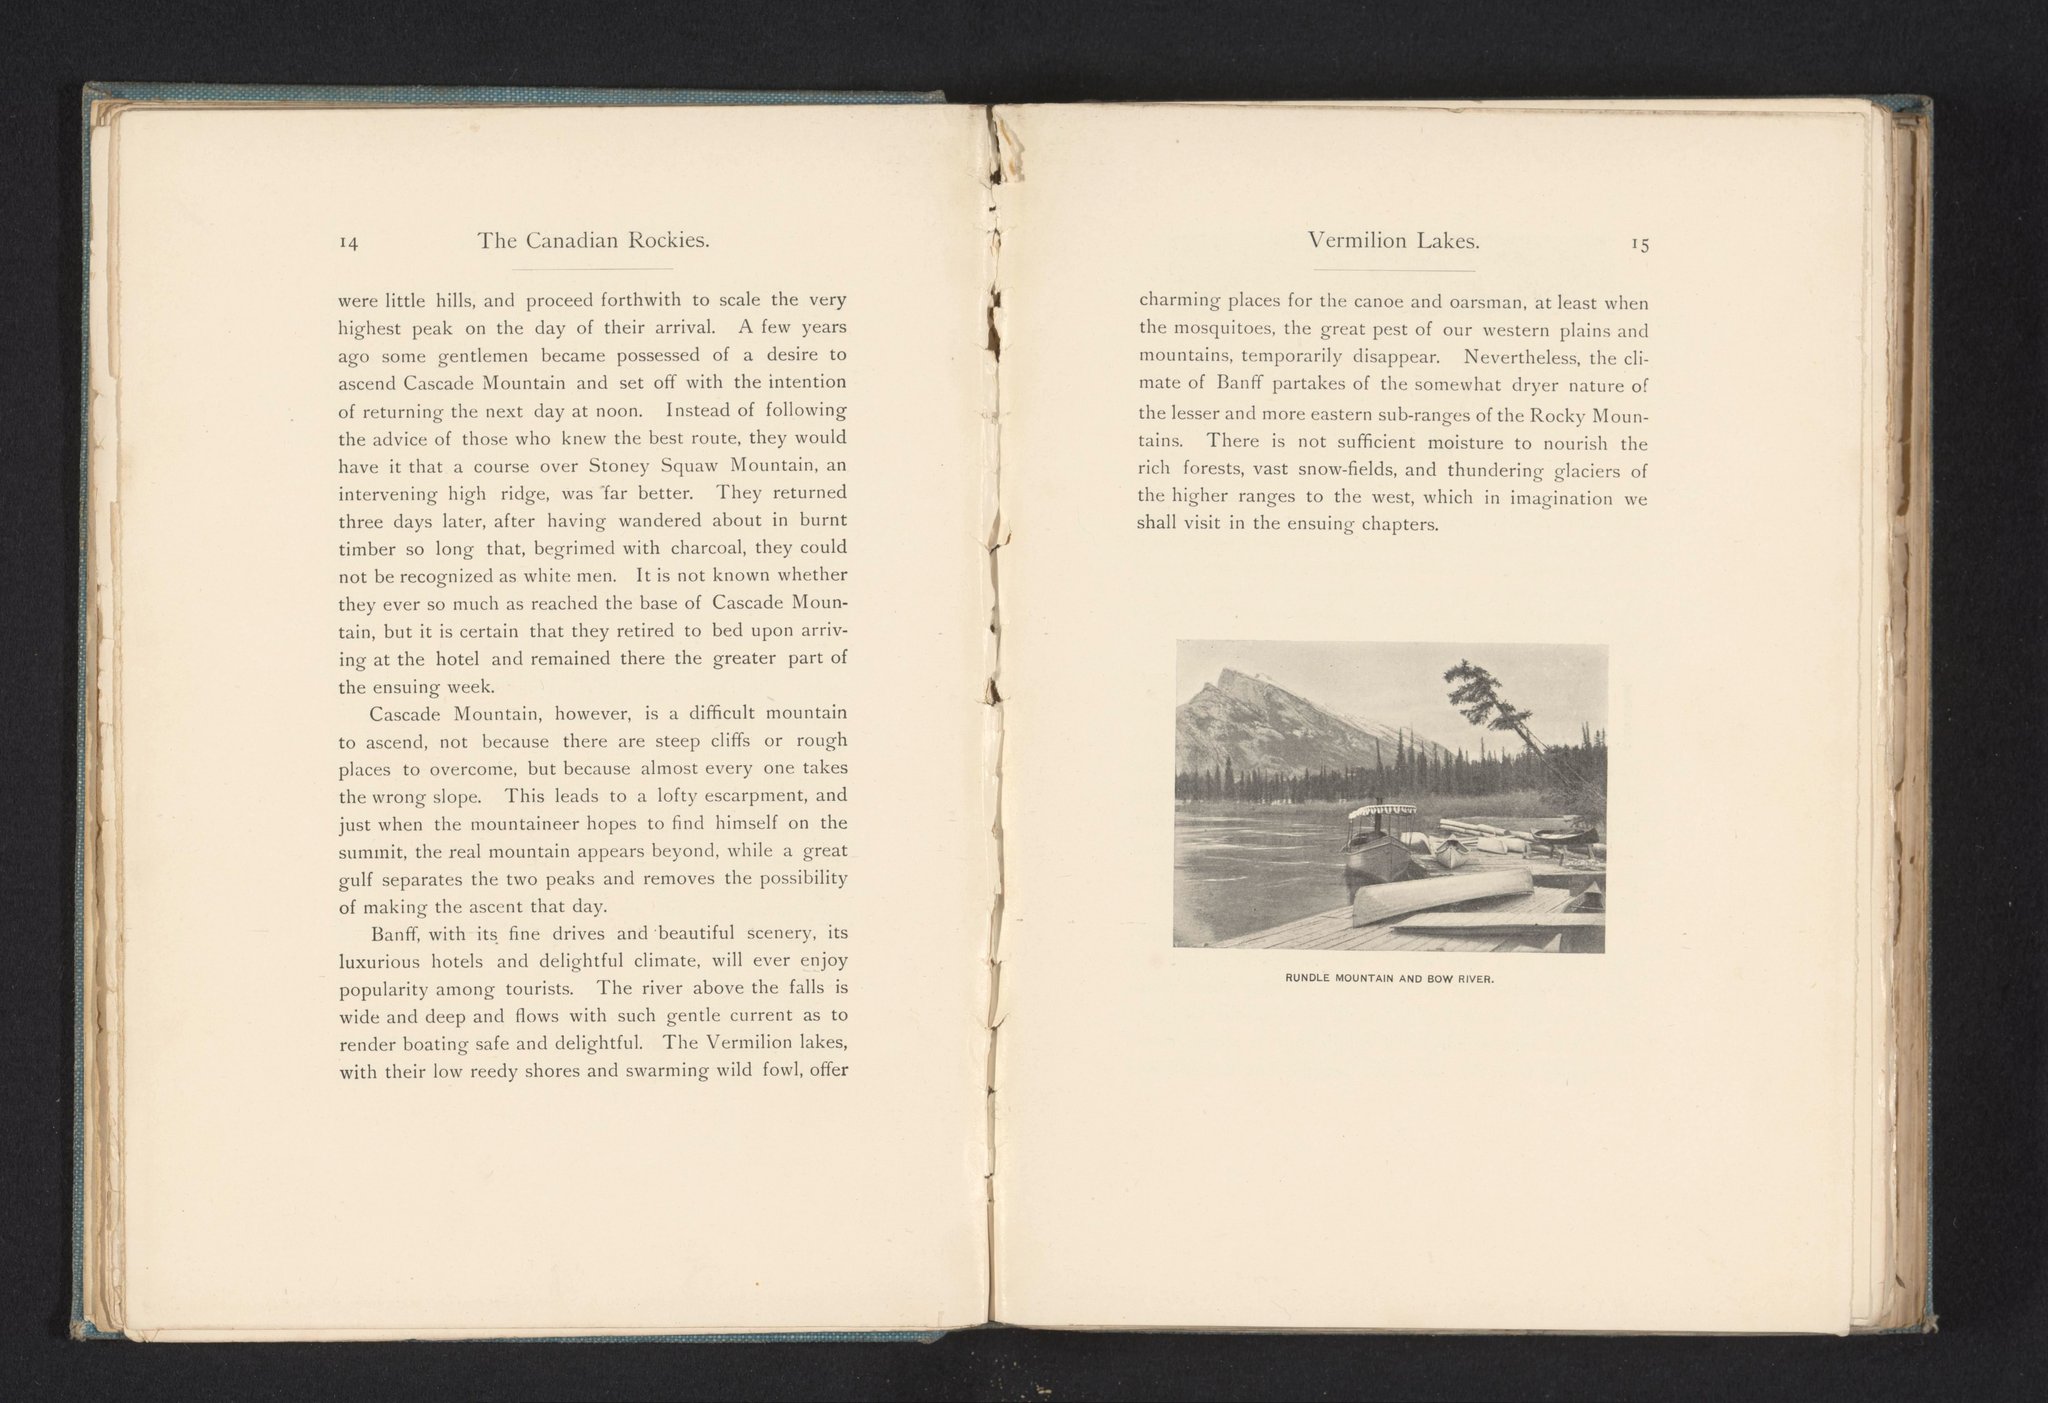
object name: page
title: Boot op de Bow, met op de achtergrond Mount Rundle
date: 1893-1897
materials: paper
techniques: autotype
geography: alberta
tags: river, mountains